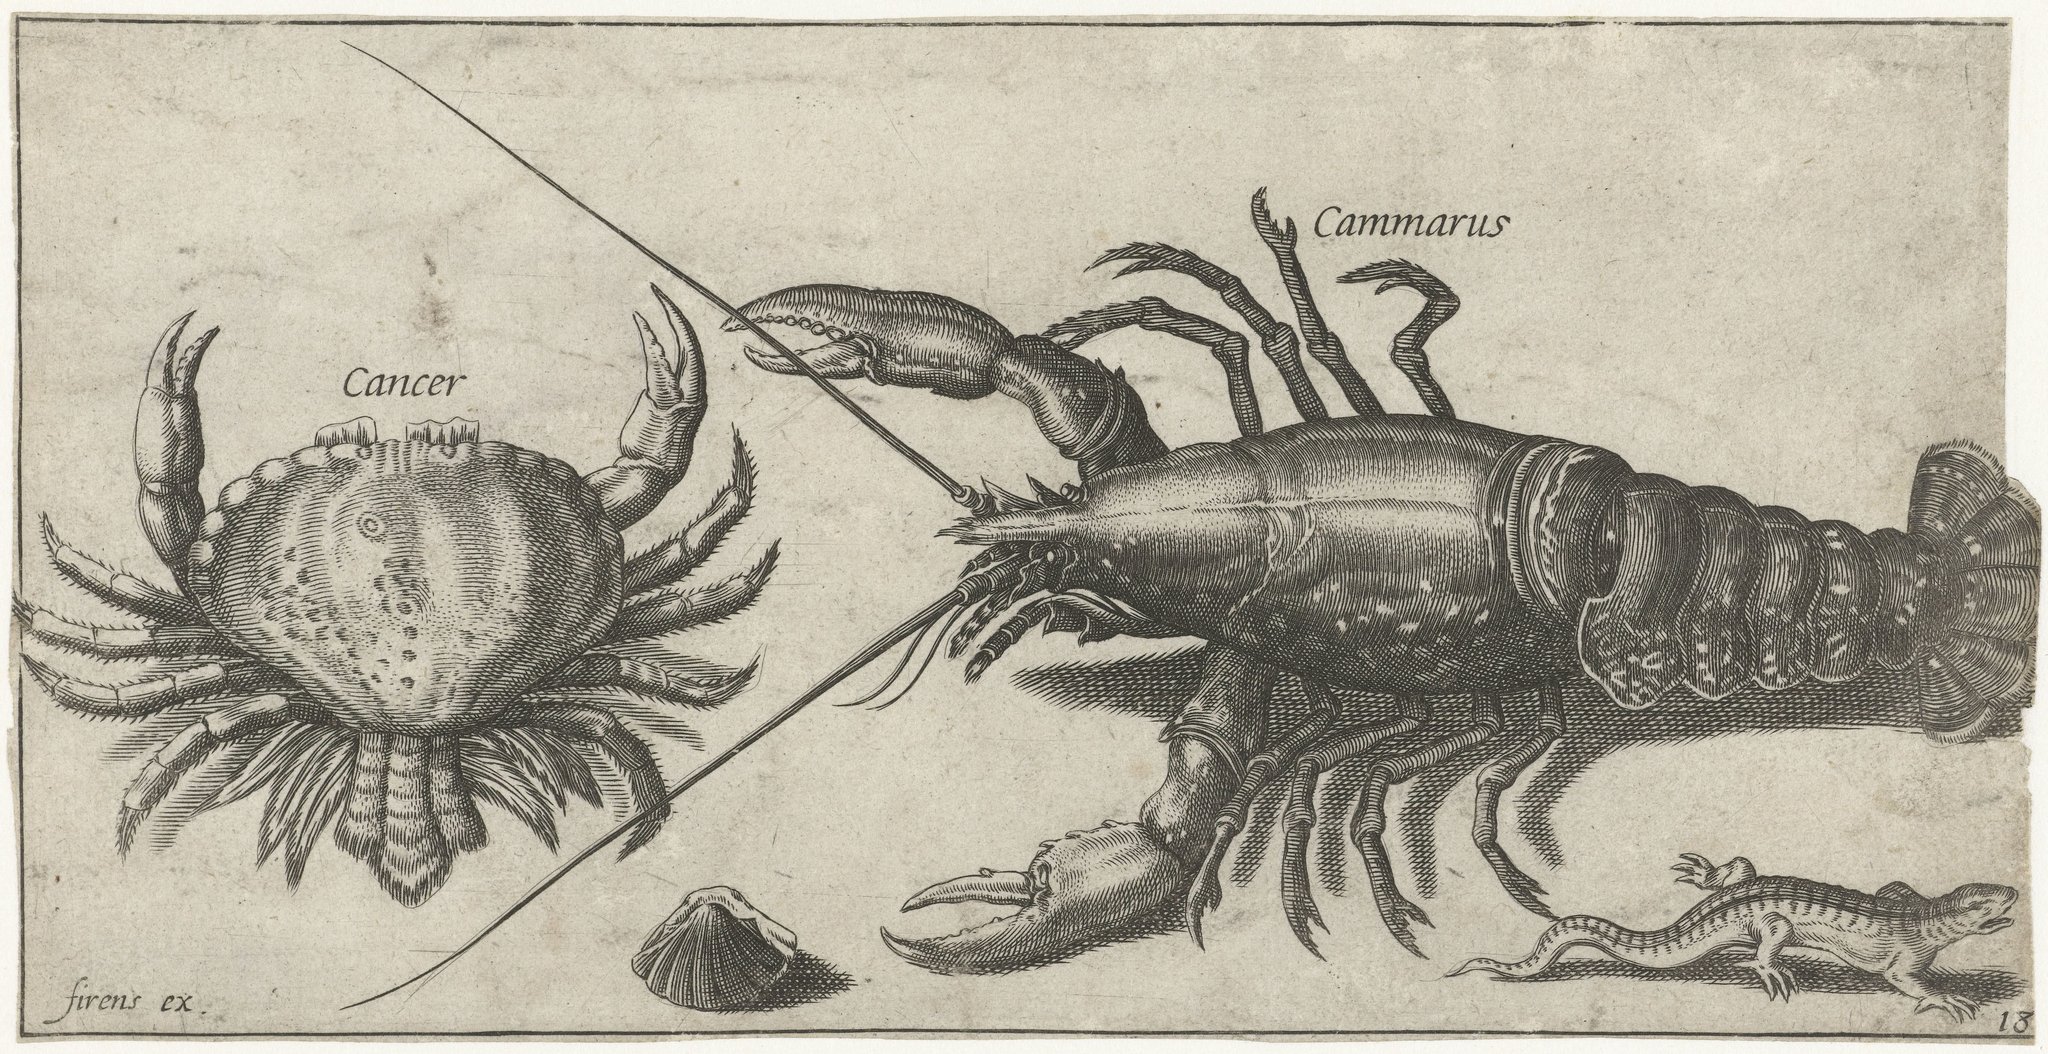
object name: print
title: Kreeft, krab, salamander en een schelp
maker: pierre firens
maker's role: print maker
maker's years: 1580-1638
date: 1600-1638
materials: paper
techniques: engraving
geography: paris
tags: crustaceans, molluscs (+ shell, snail-shell etc.)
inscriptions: collector's mark: Lugt 2228